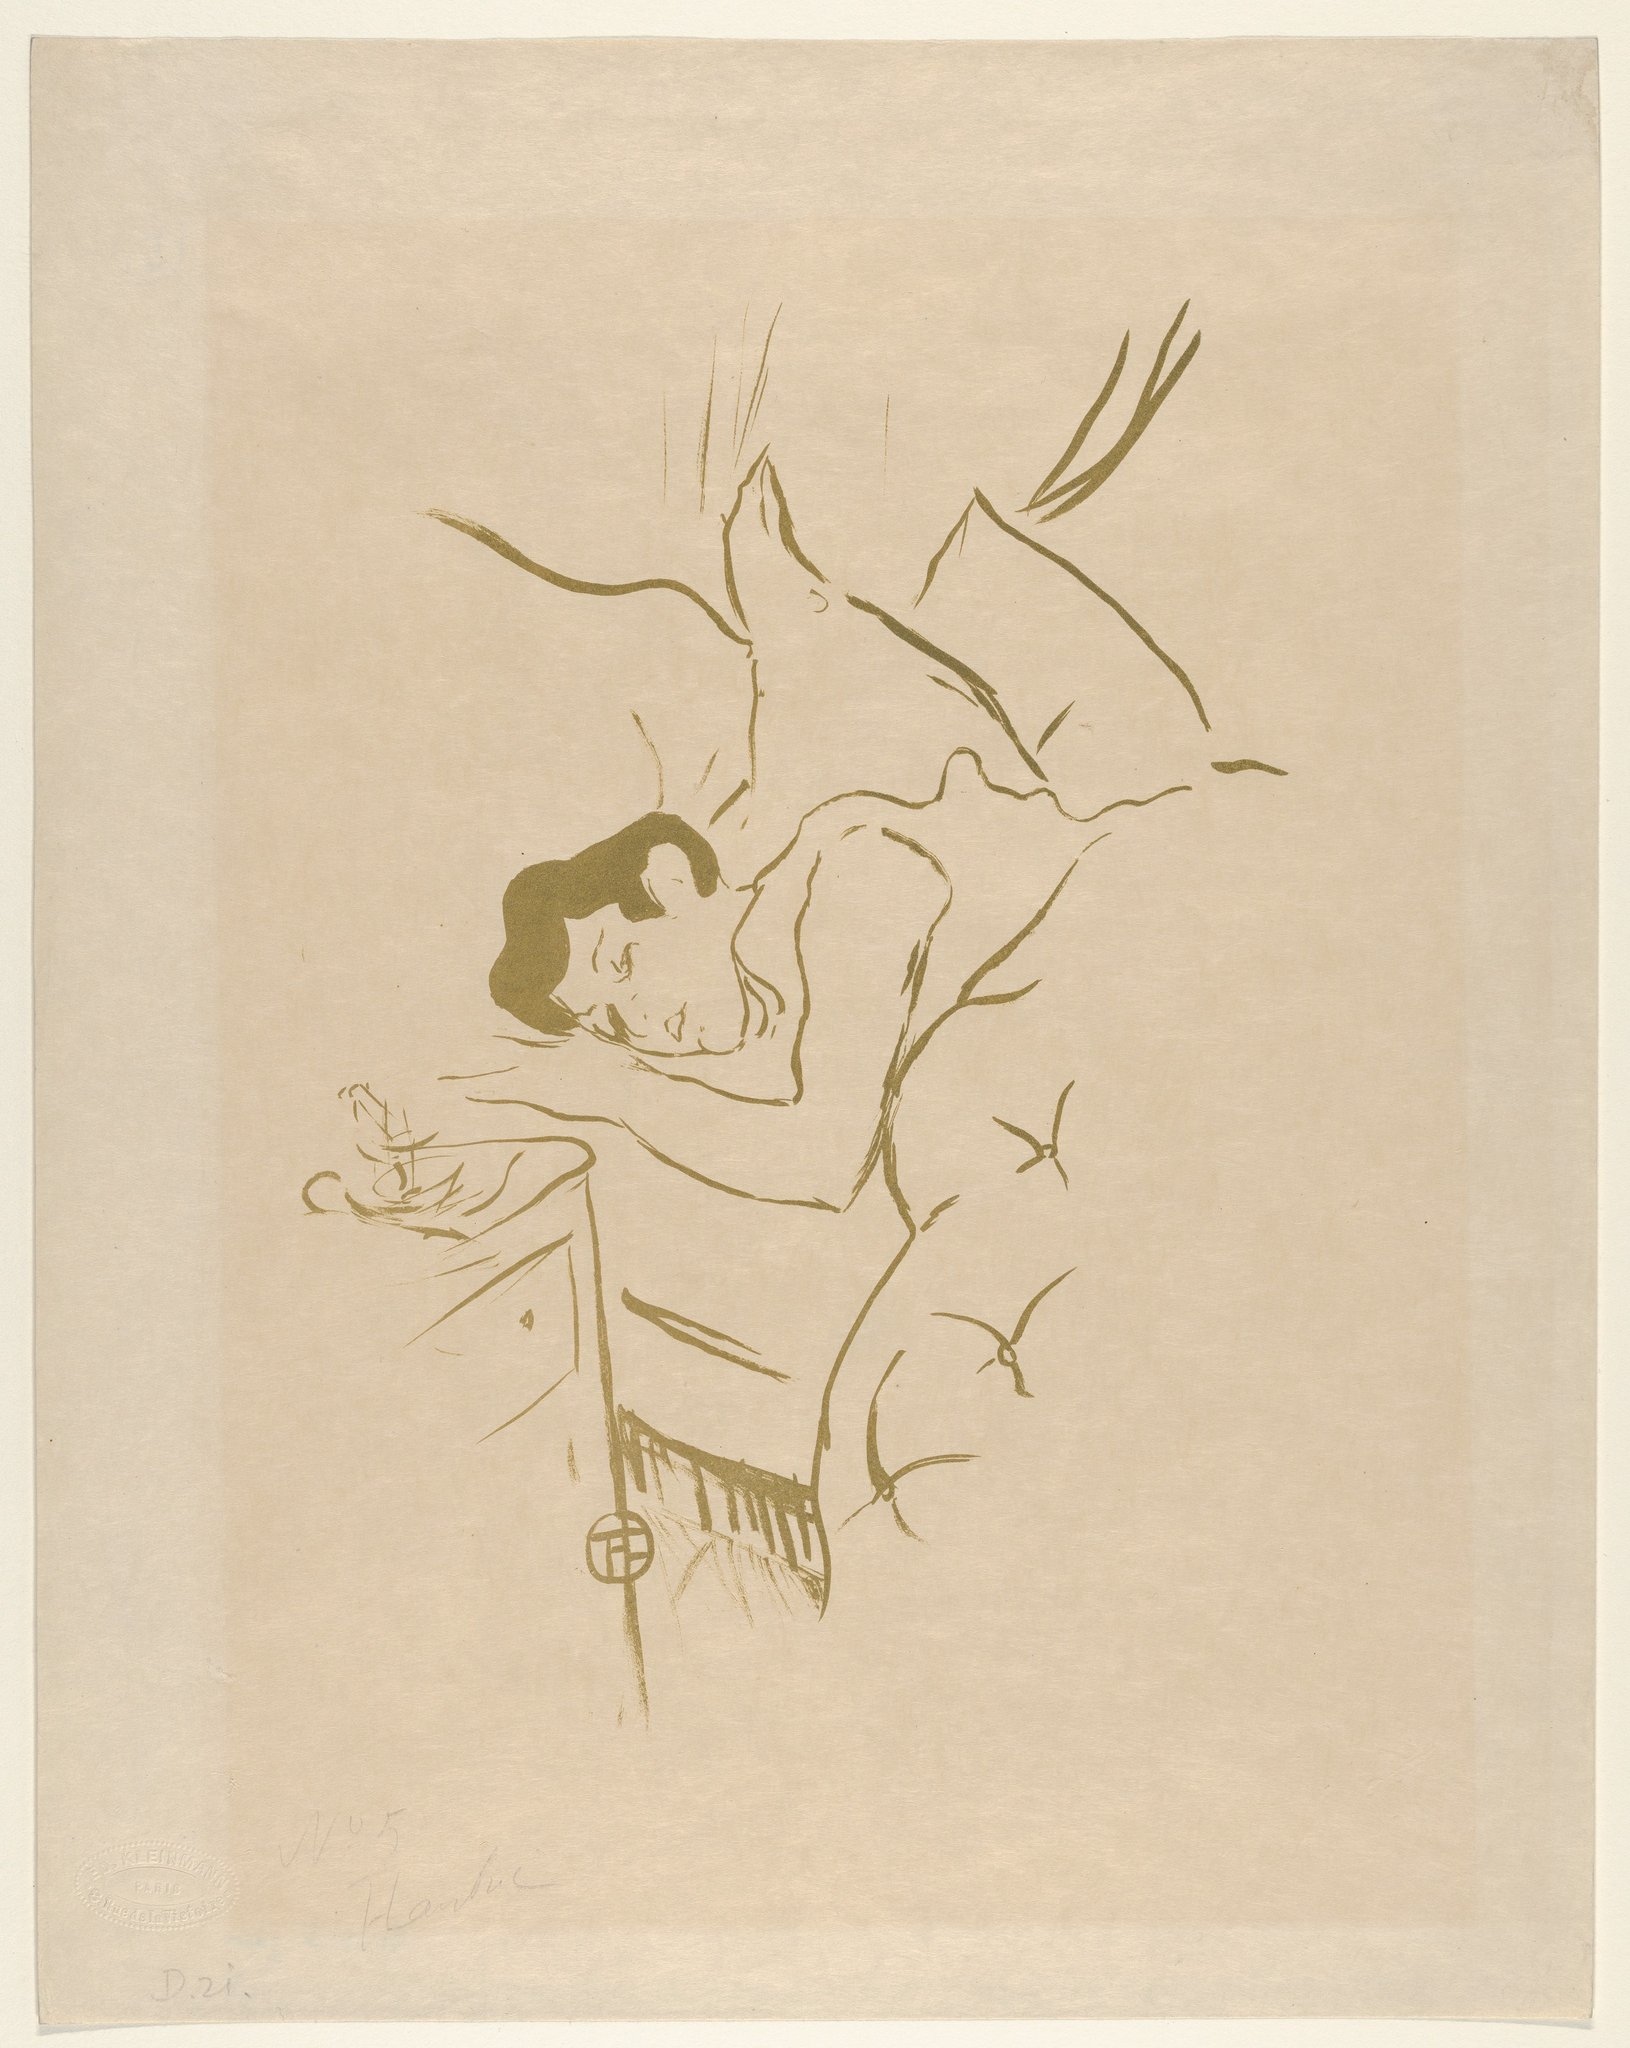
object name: print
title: Your Mouth (from Les Vieilles Histoires)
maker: henri de toulouse-lautrec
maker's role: artist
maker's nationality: french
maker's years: 1864-1901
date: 1893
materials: paper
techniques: lithograph, printing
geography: france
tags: sleeping,men